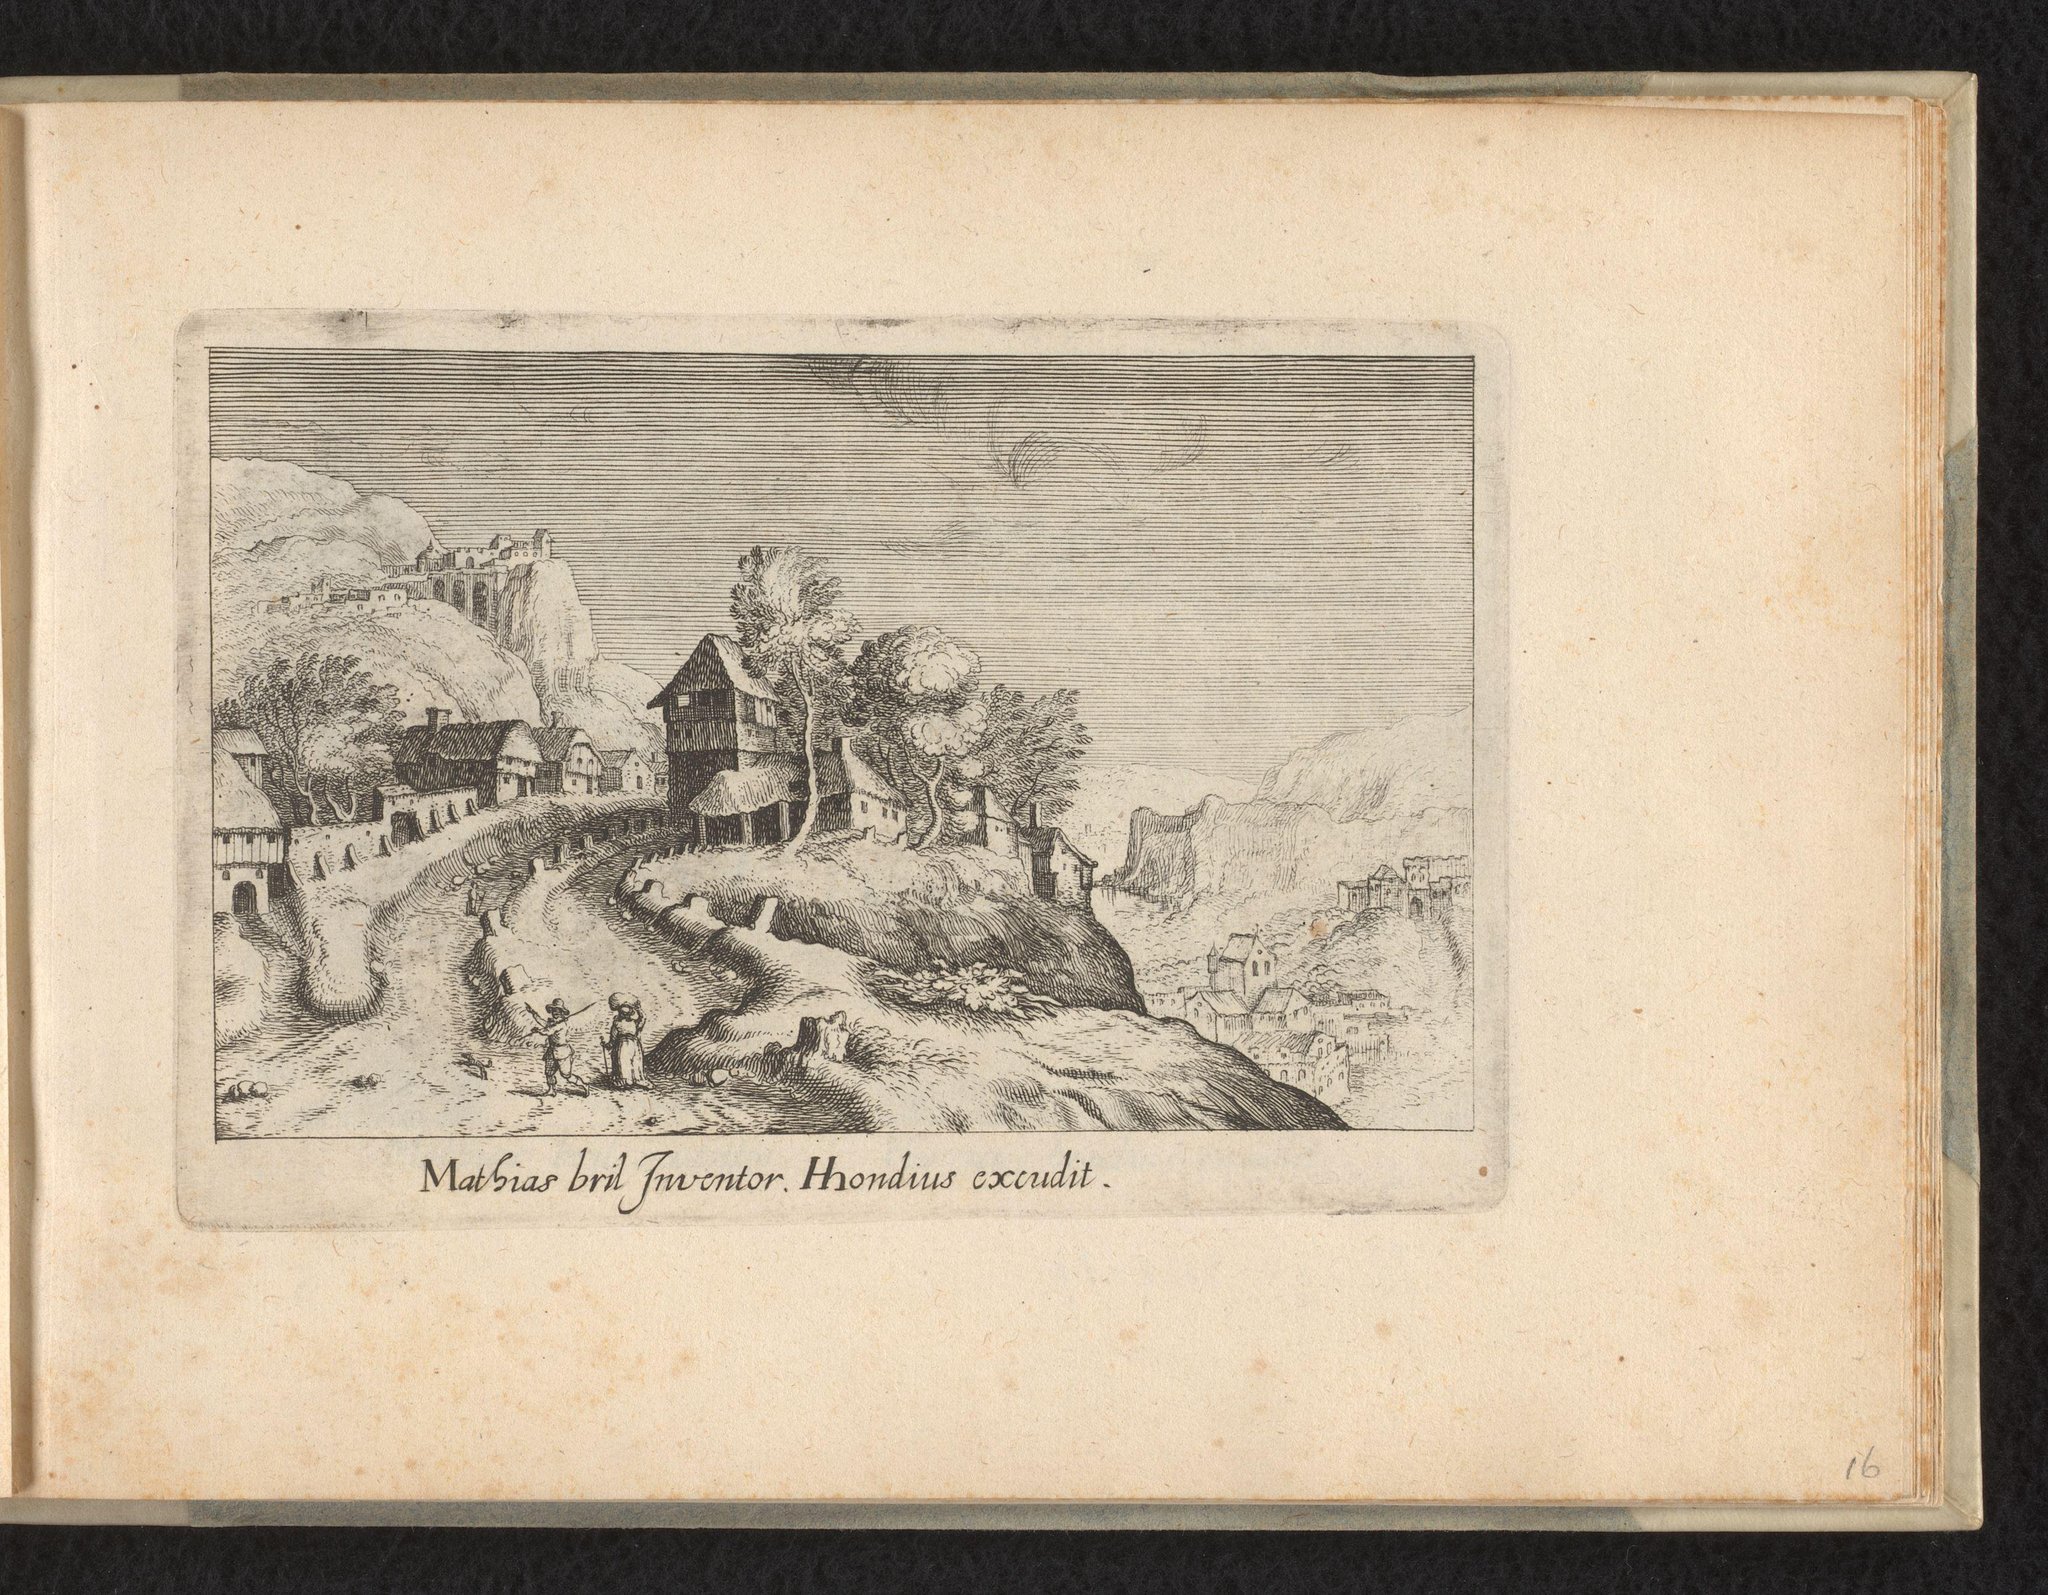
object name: print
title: Topographia Variarum Regionum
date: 1614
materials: paper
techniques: etching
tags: village, road, path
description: Op de voorgrond een man en een vrouw op een landweg. De vrouw draagt een pak op het hoofd. De landweg loopt langs huizen een een muur. Rechts een dal.